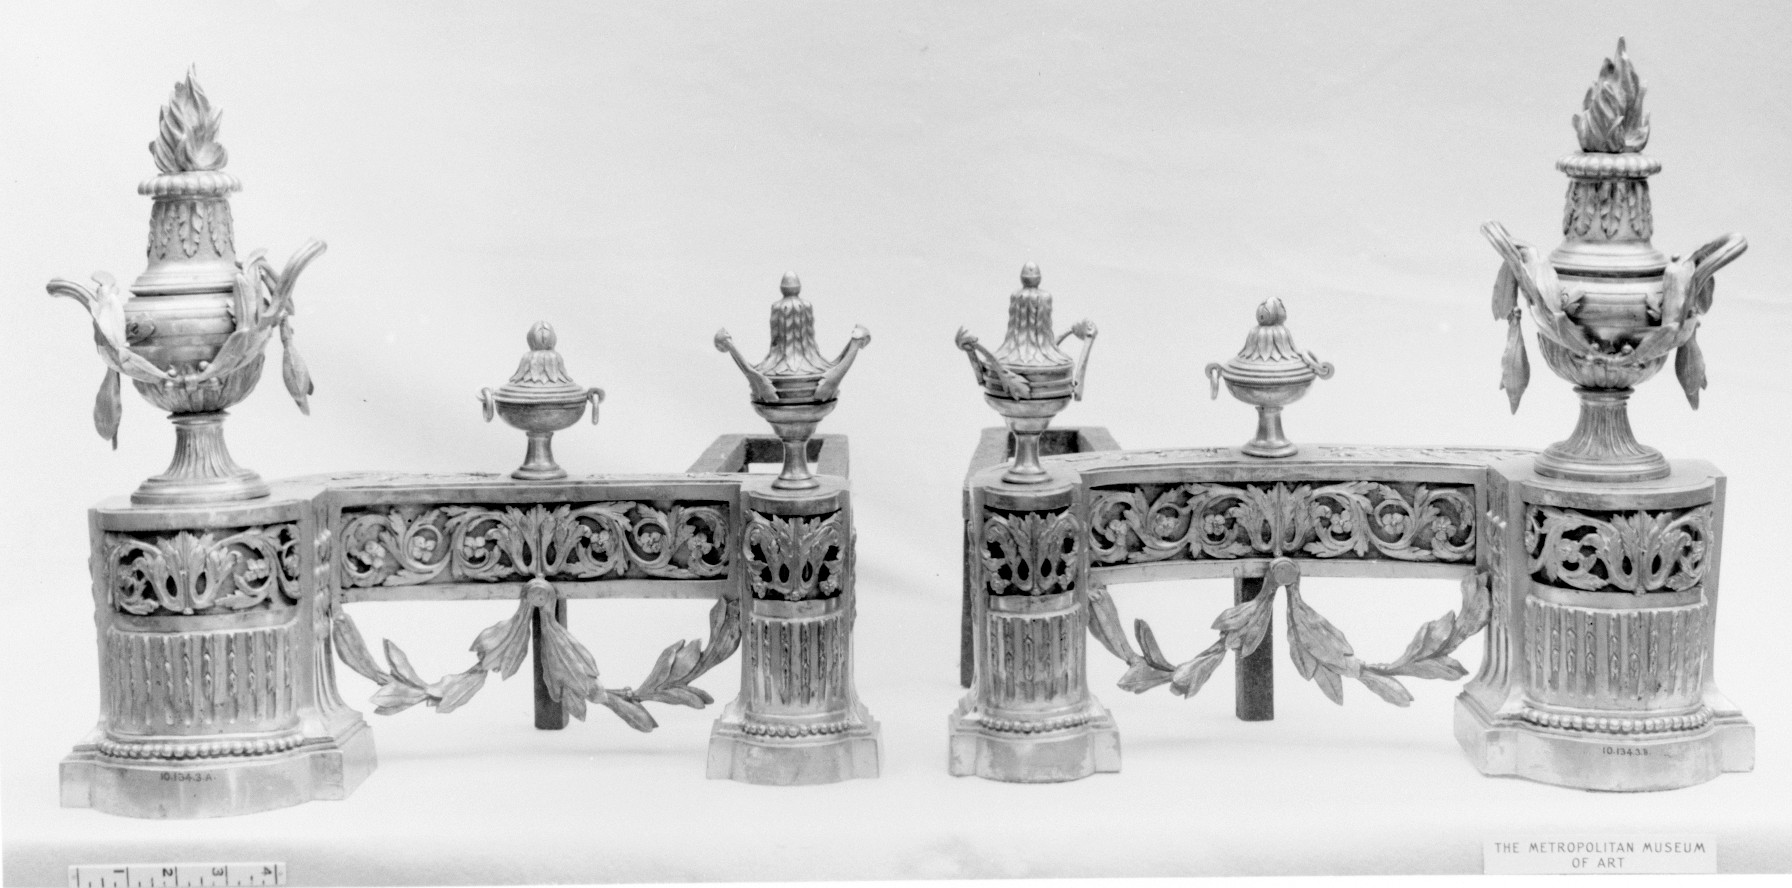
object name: firedog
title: Pair of firedogs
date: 1760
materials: gilt bronze